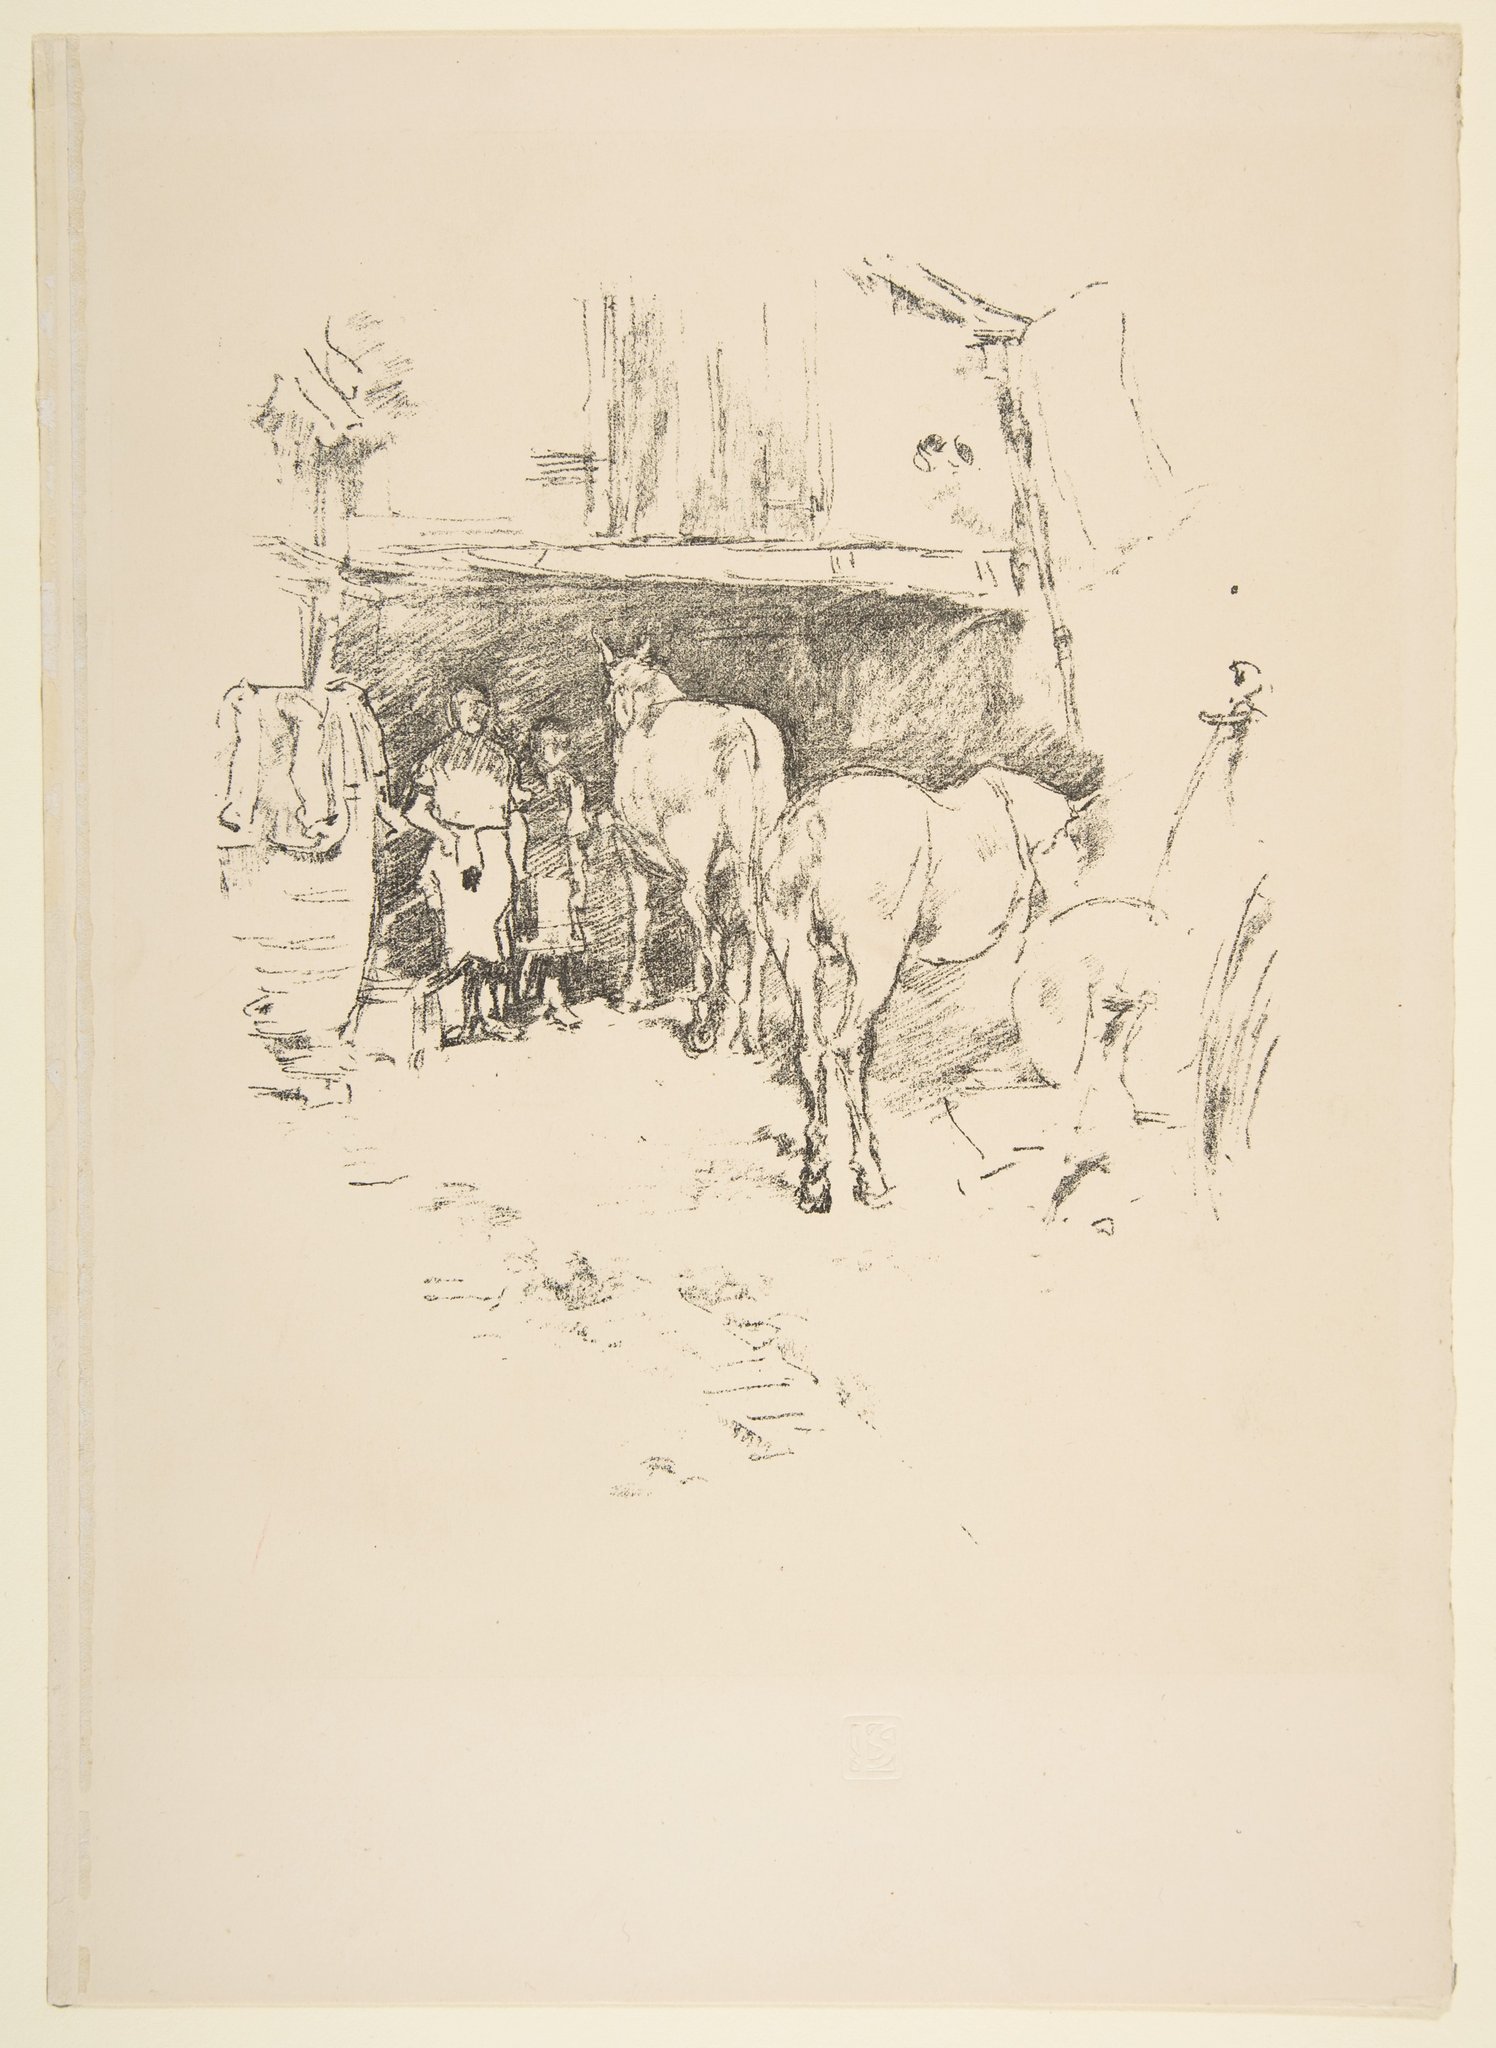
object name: print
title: The Smith's Yard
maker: james mcneill whistler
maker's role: artist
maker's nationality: american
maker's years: 1834-1903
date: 1895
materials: stone, paper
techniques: printing, lithography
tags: human figures,horses